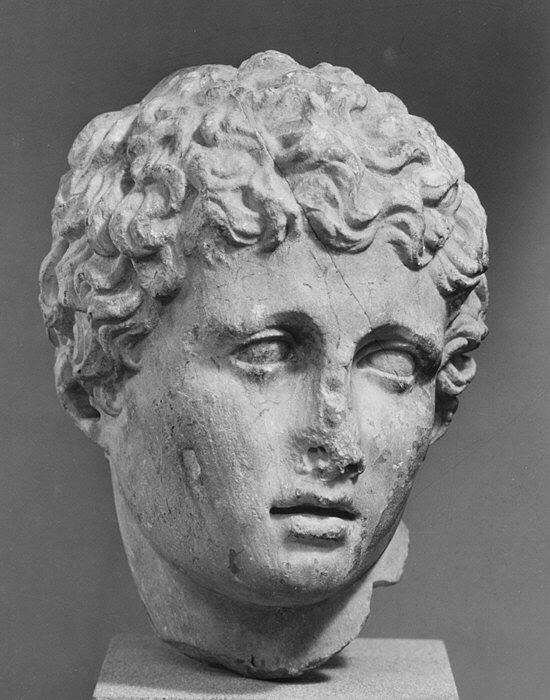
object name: head of a youth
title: Marble head of a youth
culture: roman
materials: marble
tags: heads